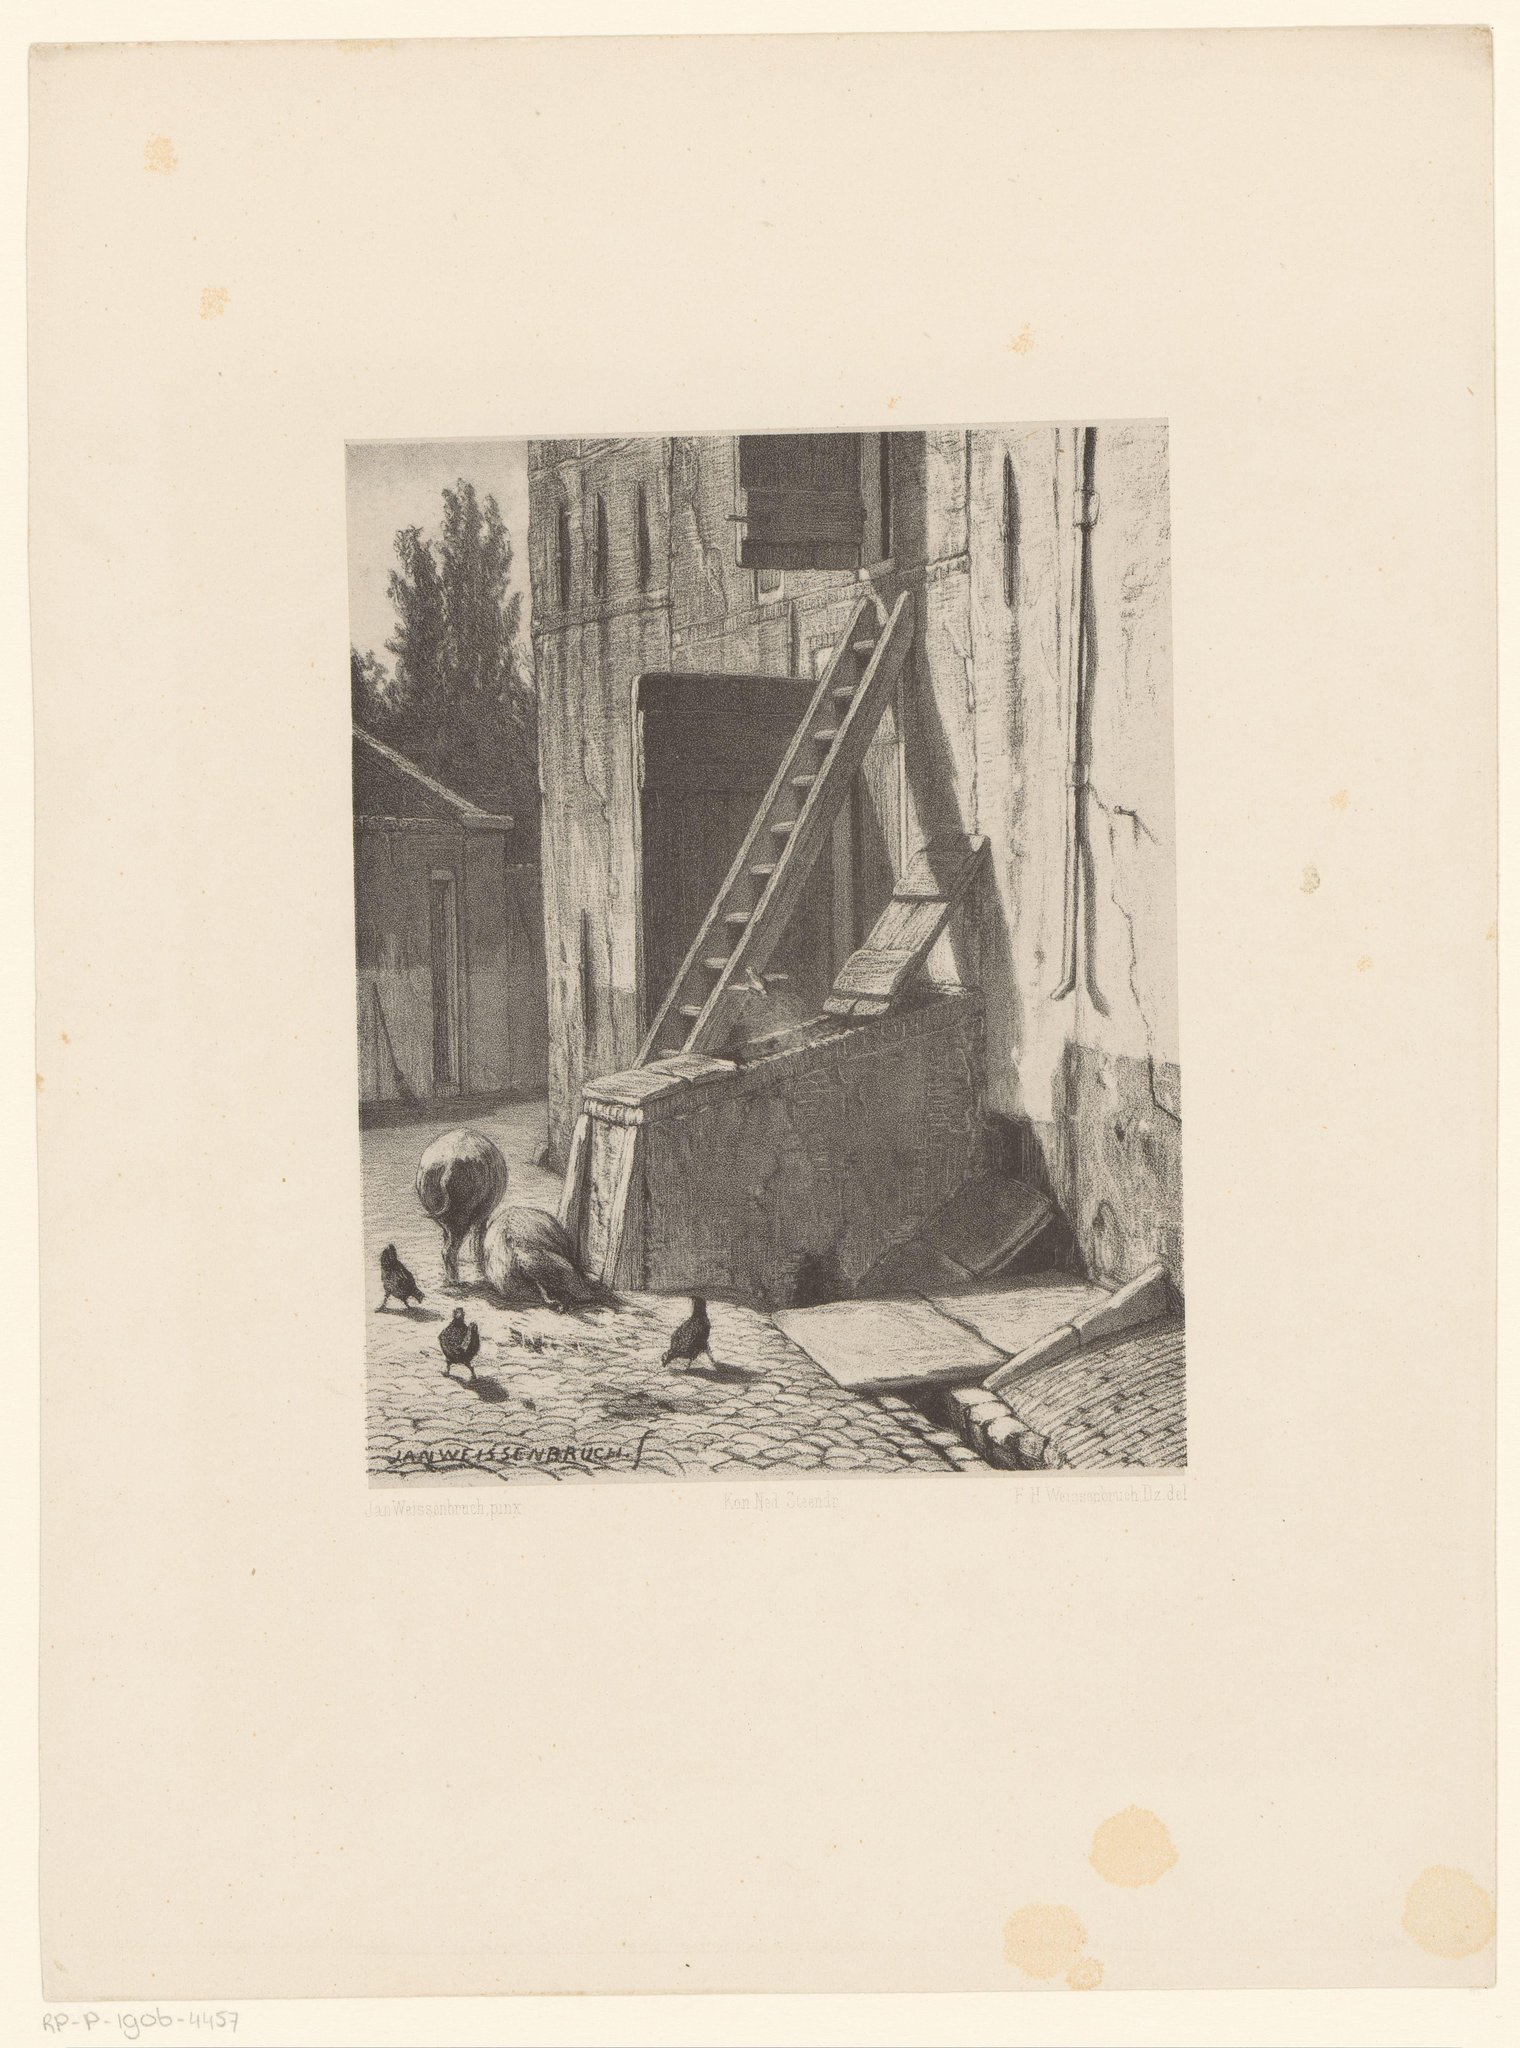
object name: print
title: Dorpsstraat met put en ladder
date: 1867-1874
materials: paper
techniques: lithograph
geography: the hague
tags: village street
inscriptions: collector's mark: Lugt 2228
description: Twee varkens en vogels in een dorpsstraat met rechts een ladder naast een open deur en een put.